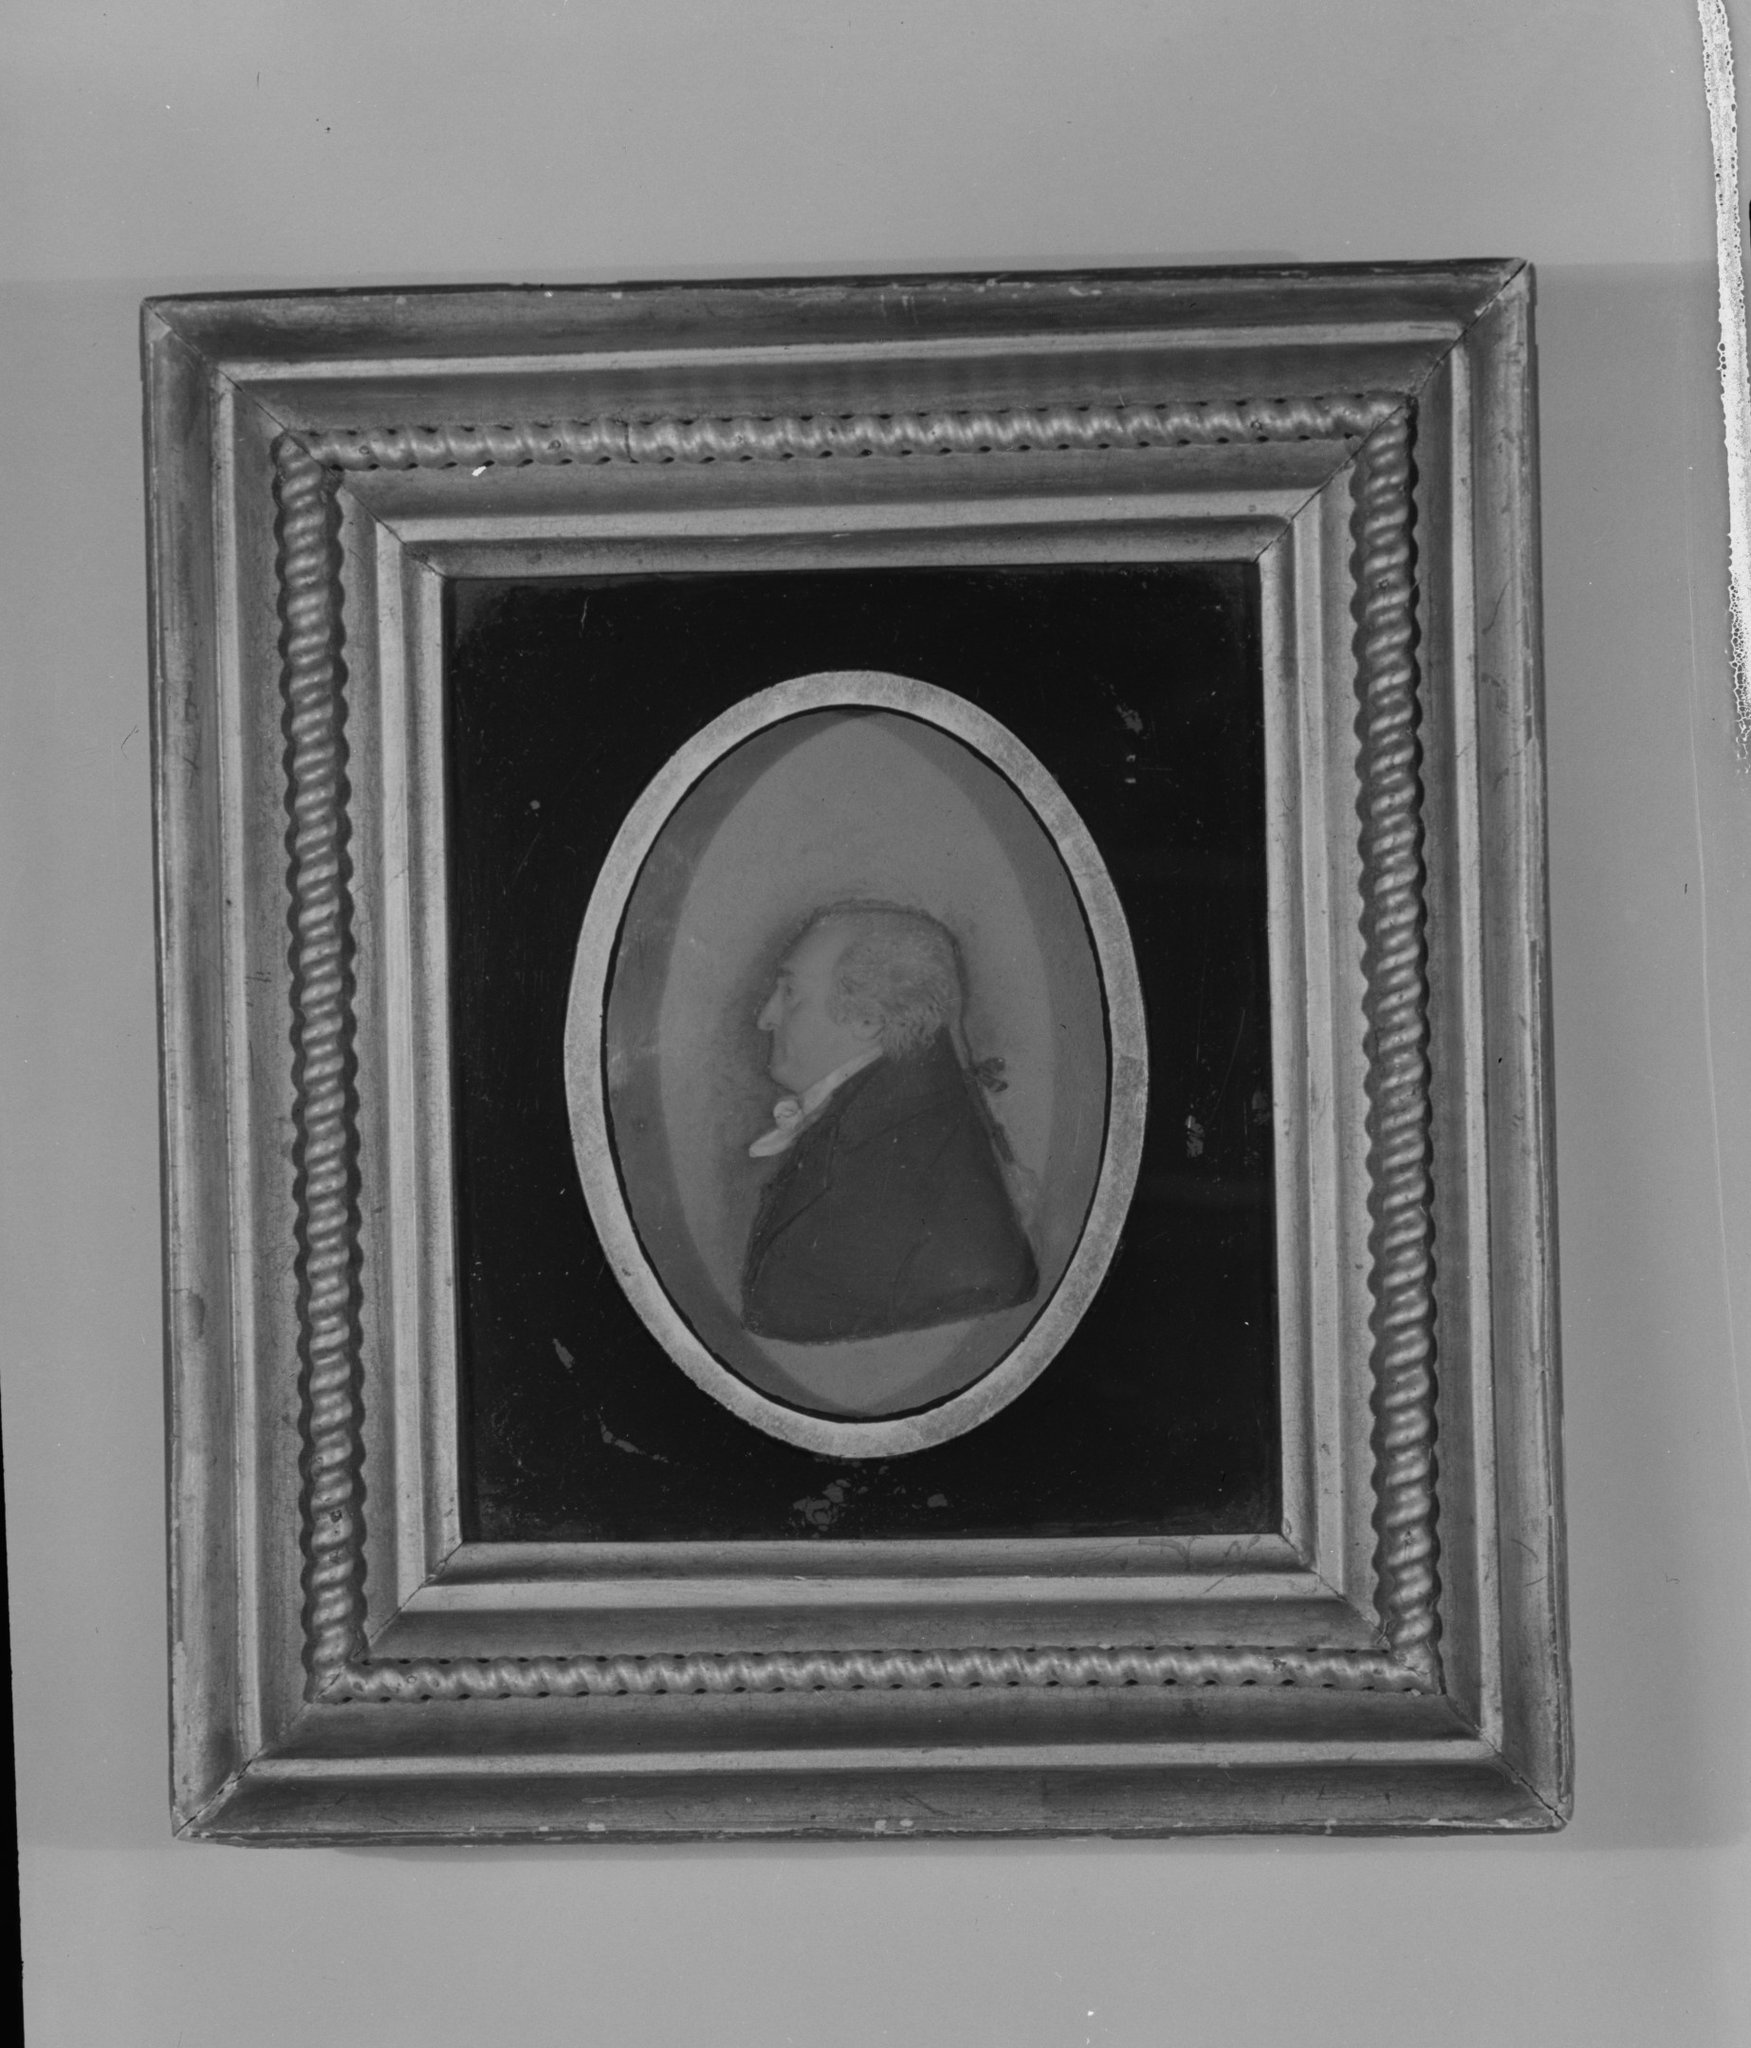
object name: miniature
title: Profile Bust of James Sullivan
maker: john christian rauschner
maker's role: maker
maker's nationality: german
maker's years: 1760-1812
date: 1800-1809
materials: glass, wax, wood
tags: men,profiles